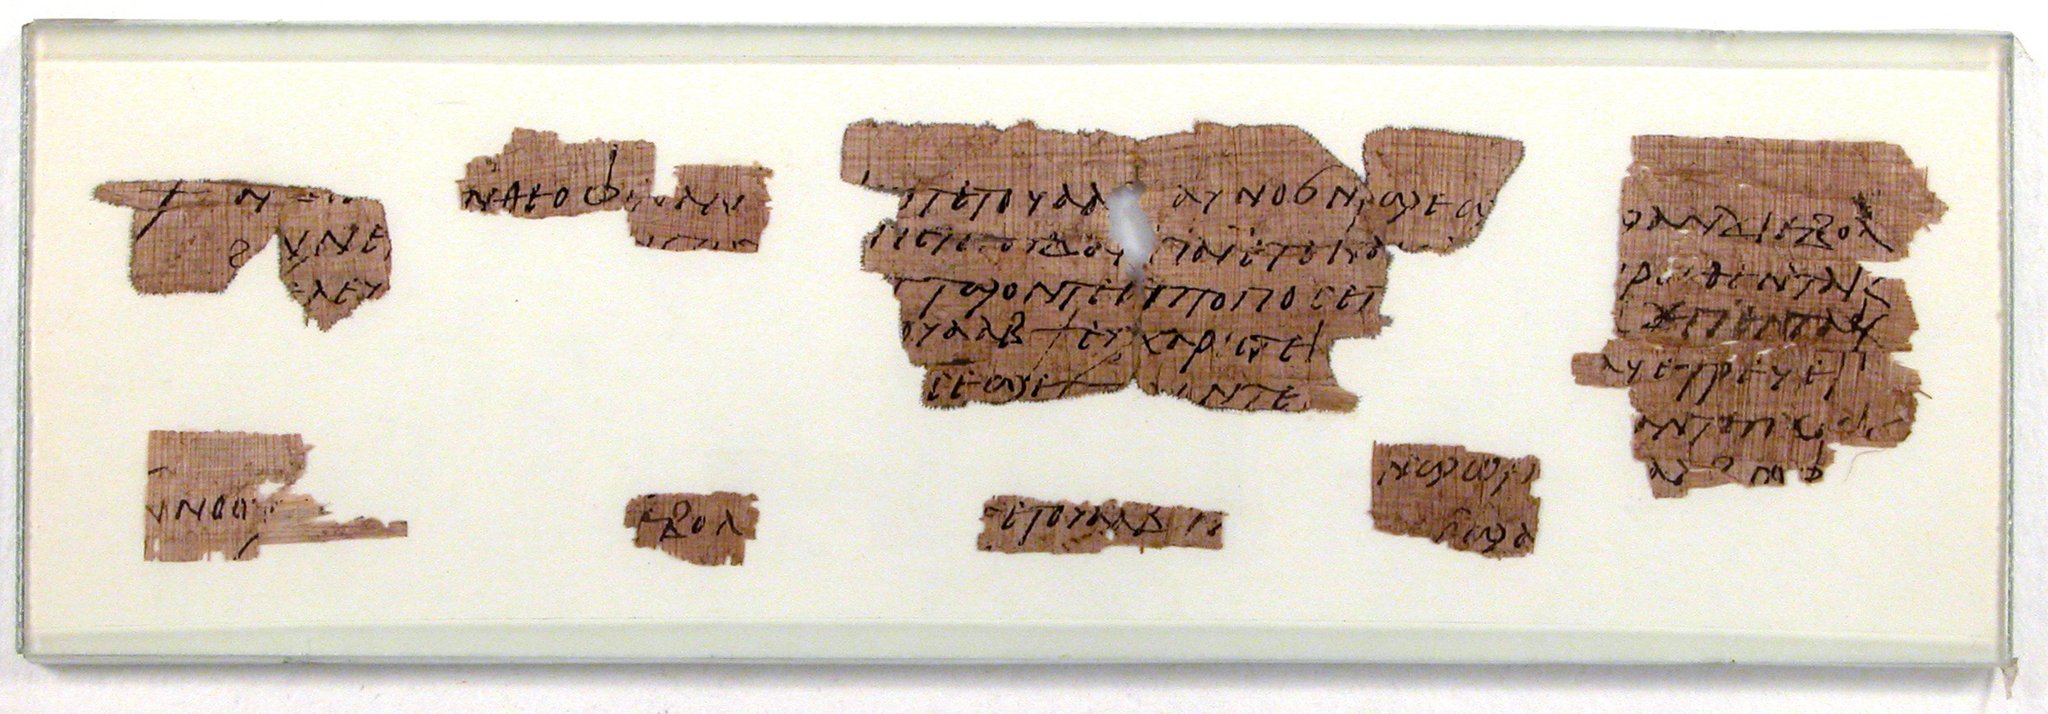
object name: fragment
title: Papyri Fragments of a Letter to Epiphanius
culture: coptic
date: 601-700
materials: ink, papyrus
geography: egypt